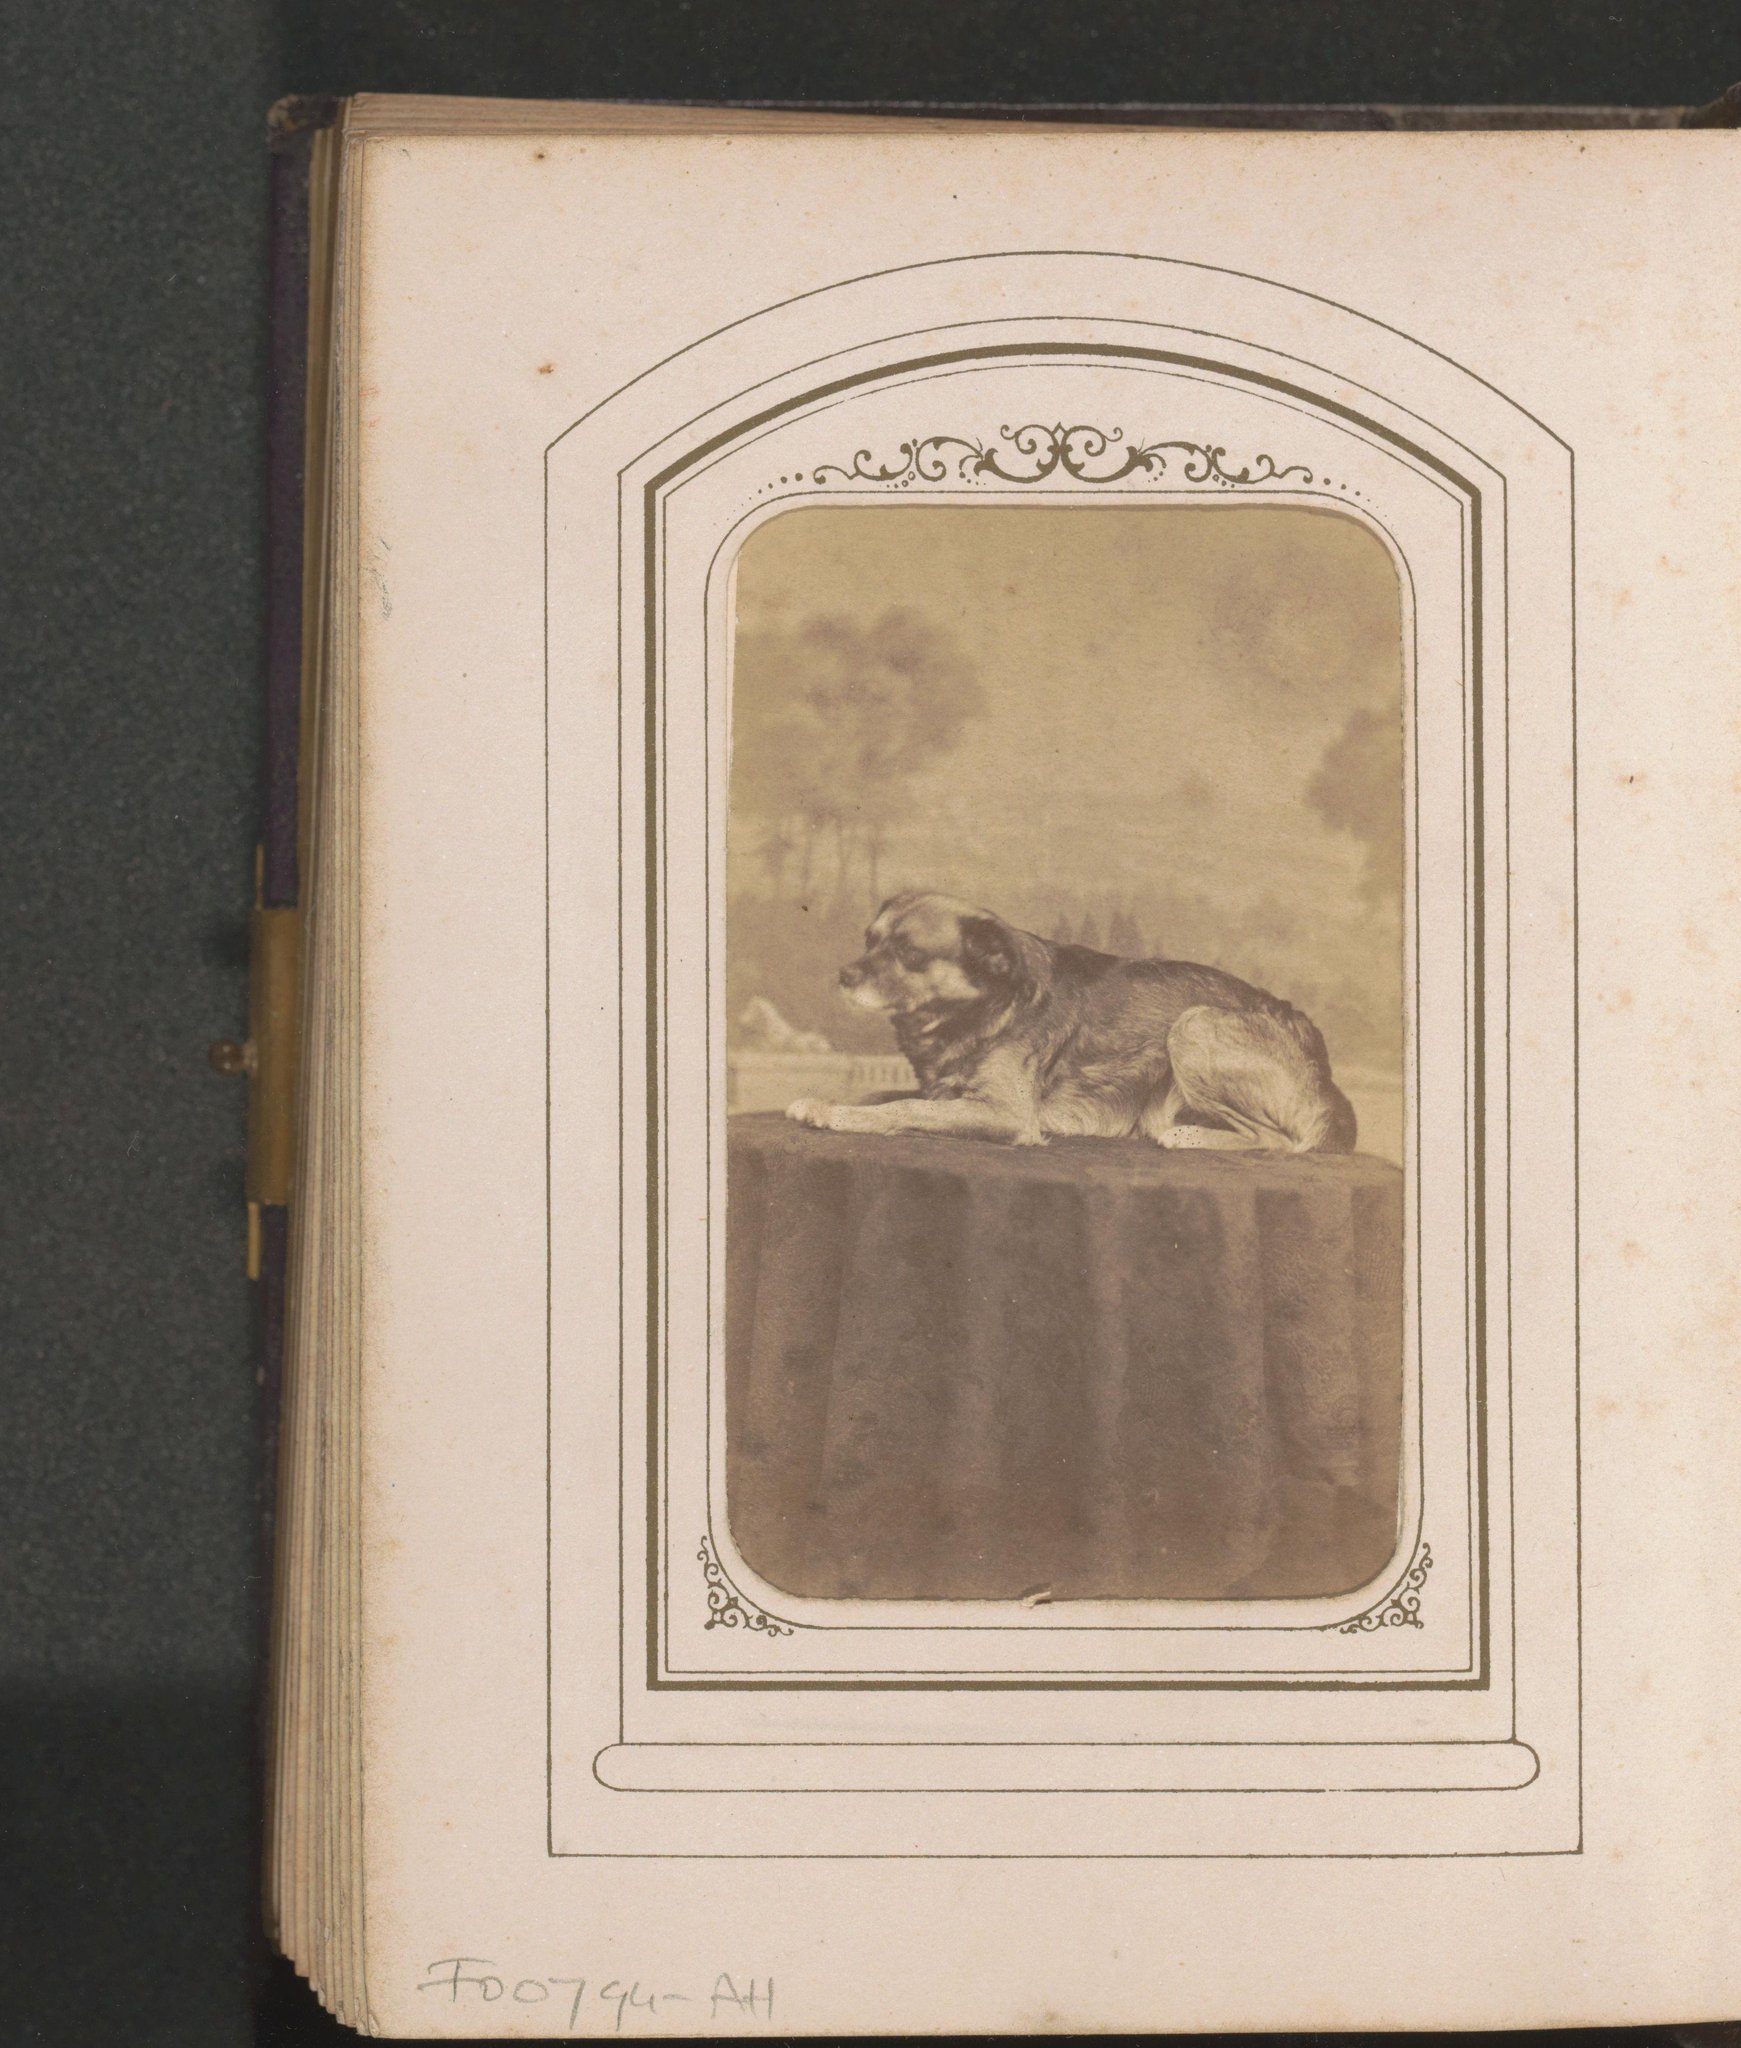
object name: photograph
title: Liggende hond genaamd Fidel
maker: l.j. goudman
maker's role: fotograaf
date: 1860-1890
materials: cardboard, paper, photographic support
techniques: albumen print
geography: amsterdam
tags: dog, amsterdam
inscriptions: inscription: ‘Fidel’, address: ‘Lange Leidsche straat No. 350 Amsterdam’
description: Onderdeel van Fotoalbum met 36 opnames van Europese landen.